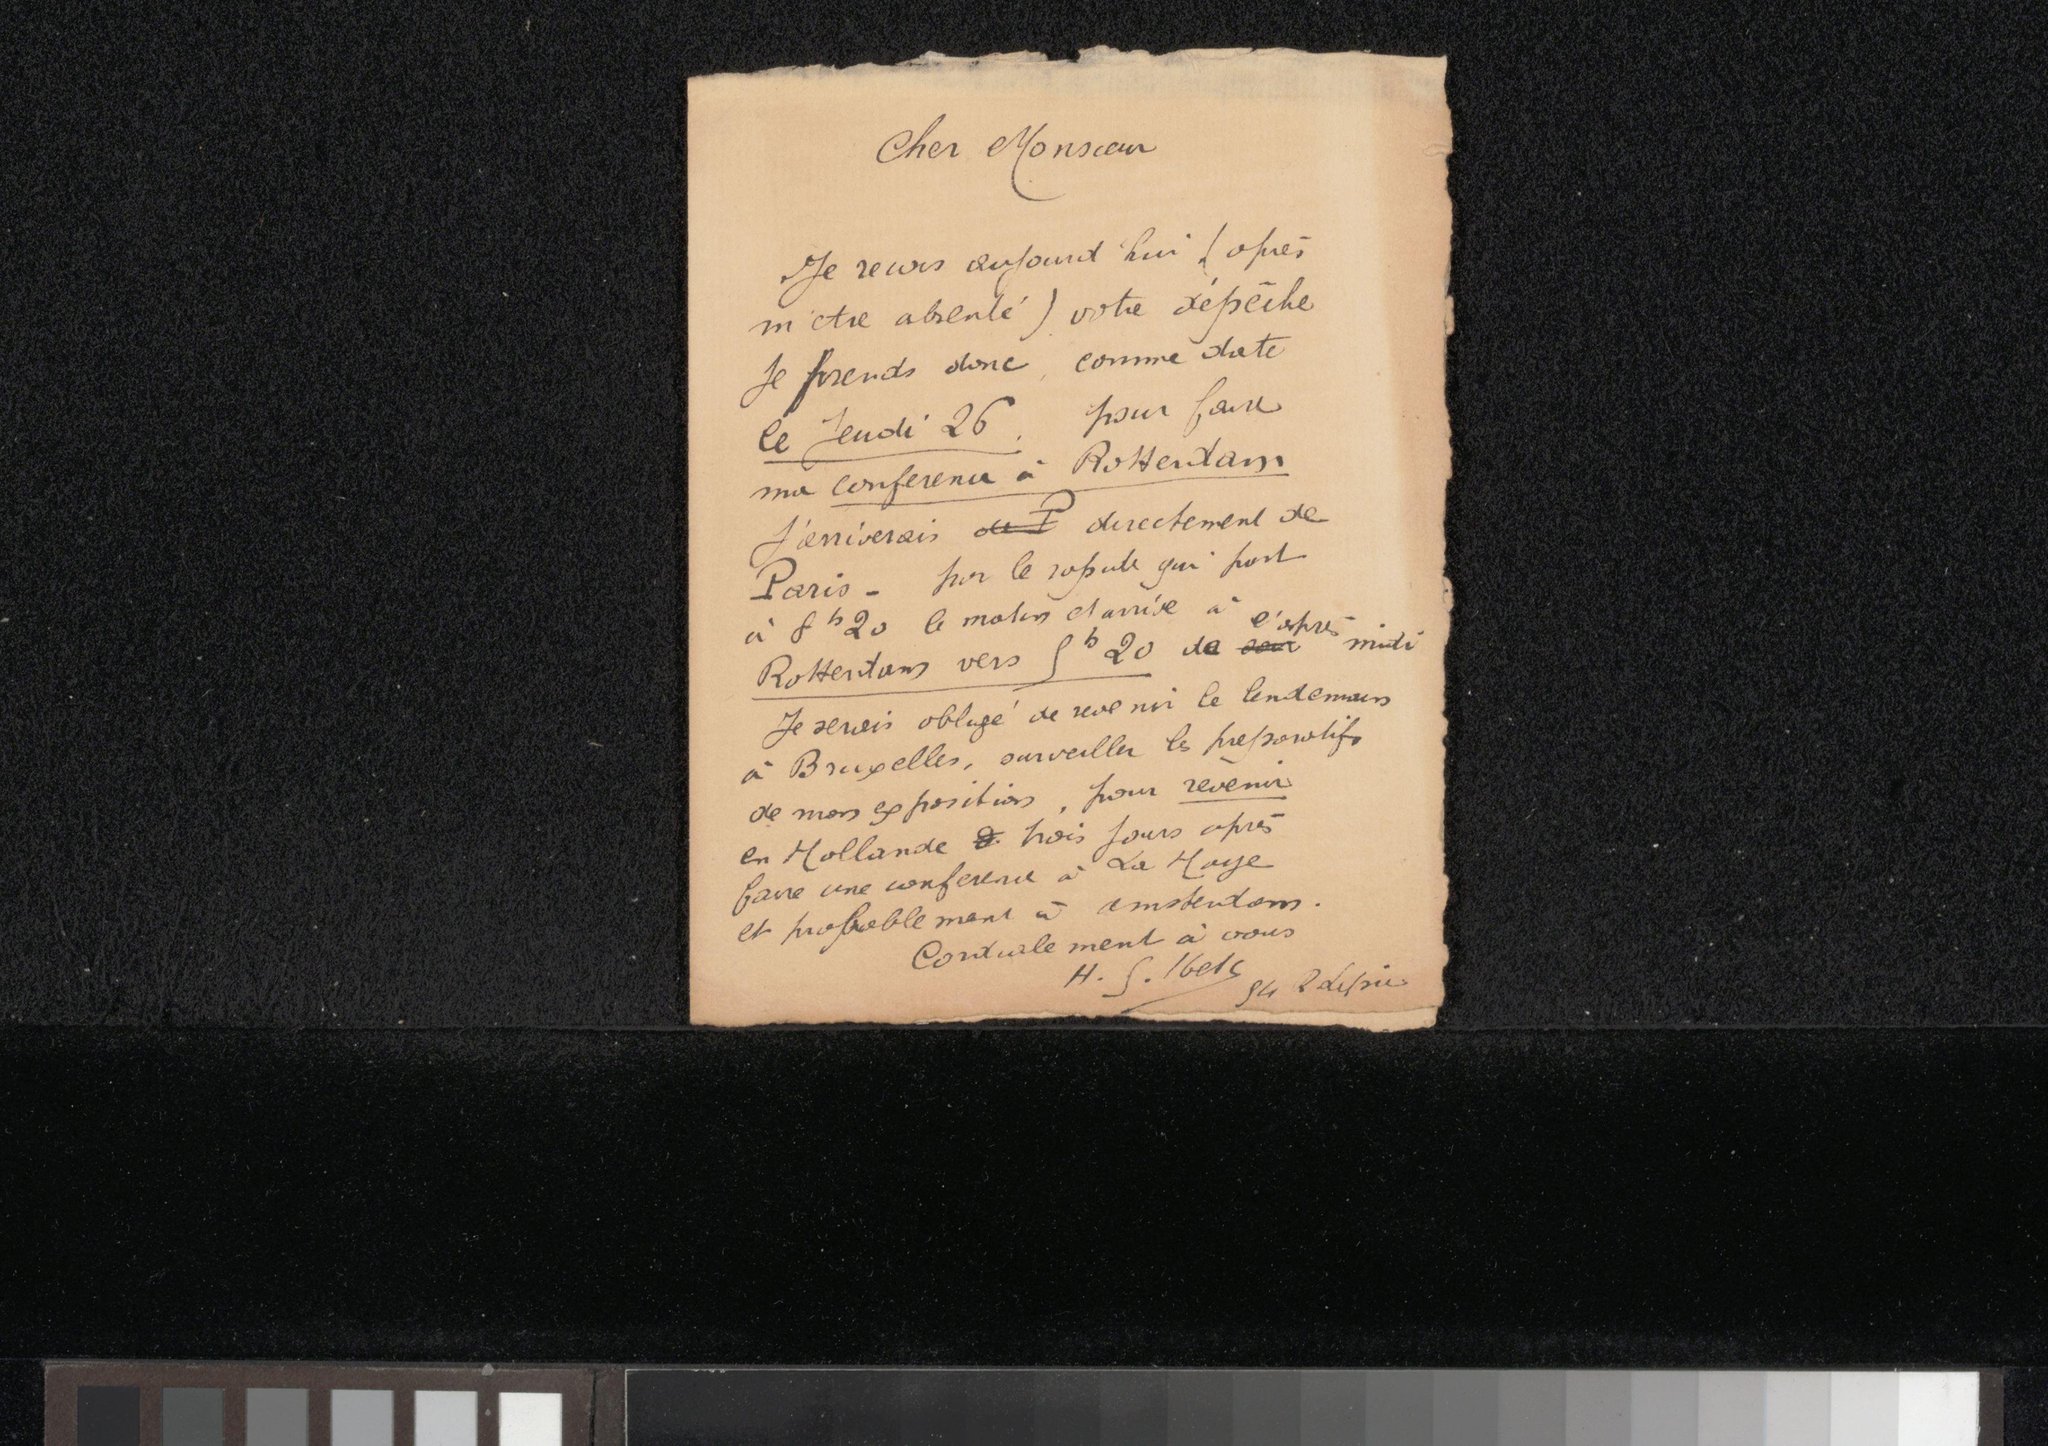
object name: letter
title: Brief aan Pieter Haverkorn van Rijsewijk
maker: henri gabriel ibels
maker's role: print maker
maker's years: 1867-1936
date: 1877-1915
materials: ink, paper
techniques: pen, writing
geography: paris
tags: pieter haverkorn van rijsewijk, exhibition ~ art, the hague, rotterdam, brussels, paris, holland